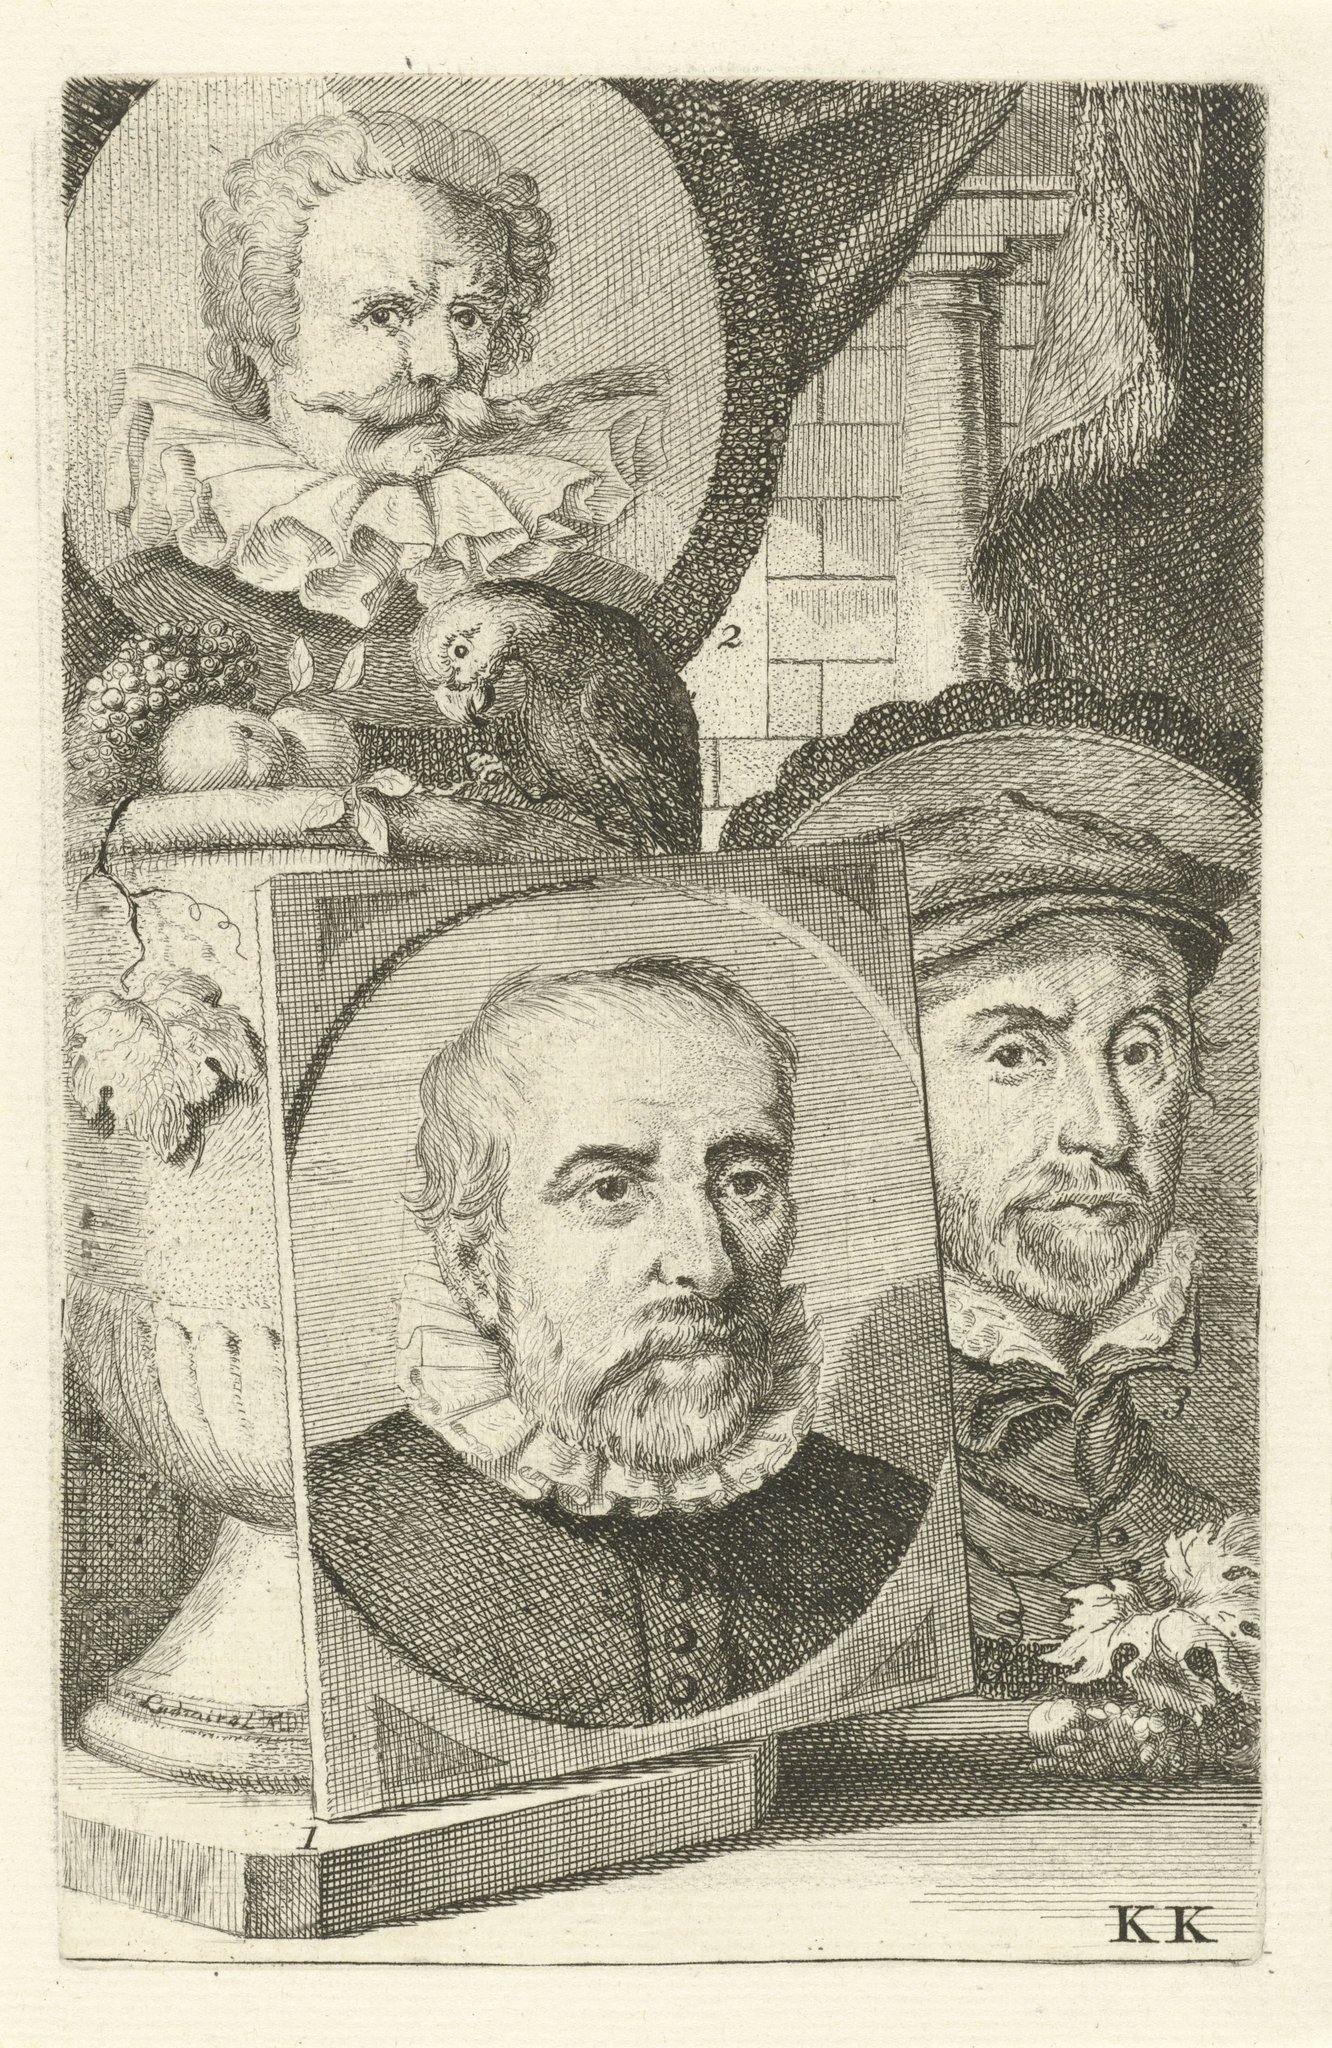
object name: print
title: Drie kunstenaarsportretten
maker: jan l admiral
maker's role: draughtsman, print maker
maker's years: 1699-1773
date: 1764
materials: paper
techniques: etching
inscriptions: collector's mark: Lugt 2228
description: Prent opgenomen in: Mander, Karel van; Jongh, Jacobus de (vert.). Het leven der doorluchtige Nederlandsche en eenige Hoogduitsche schilders. Amsterdam: Steven van Esveldt, 1764.